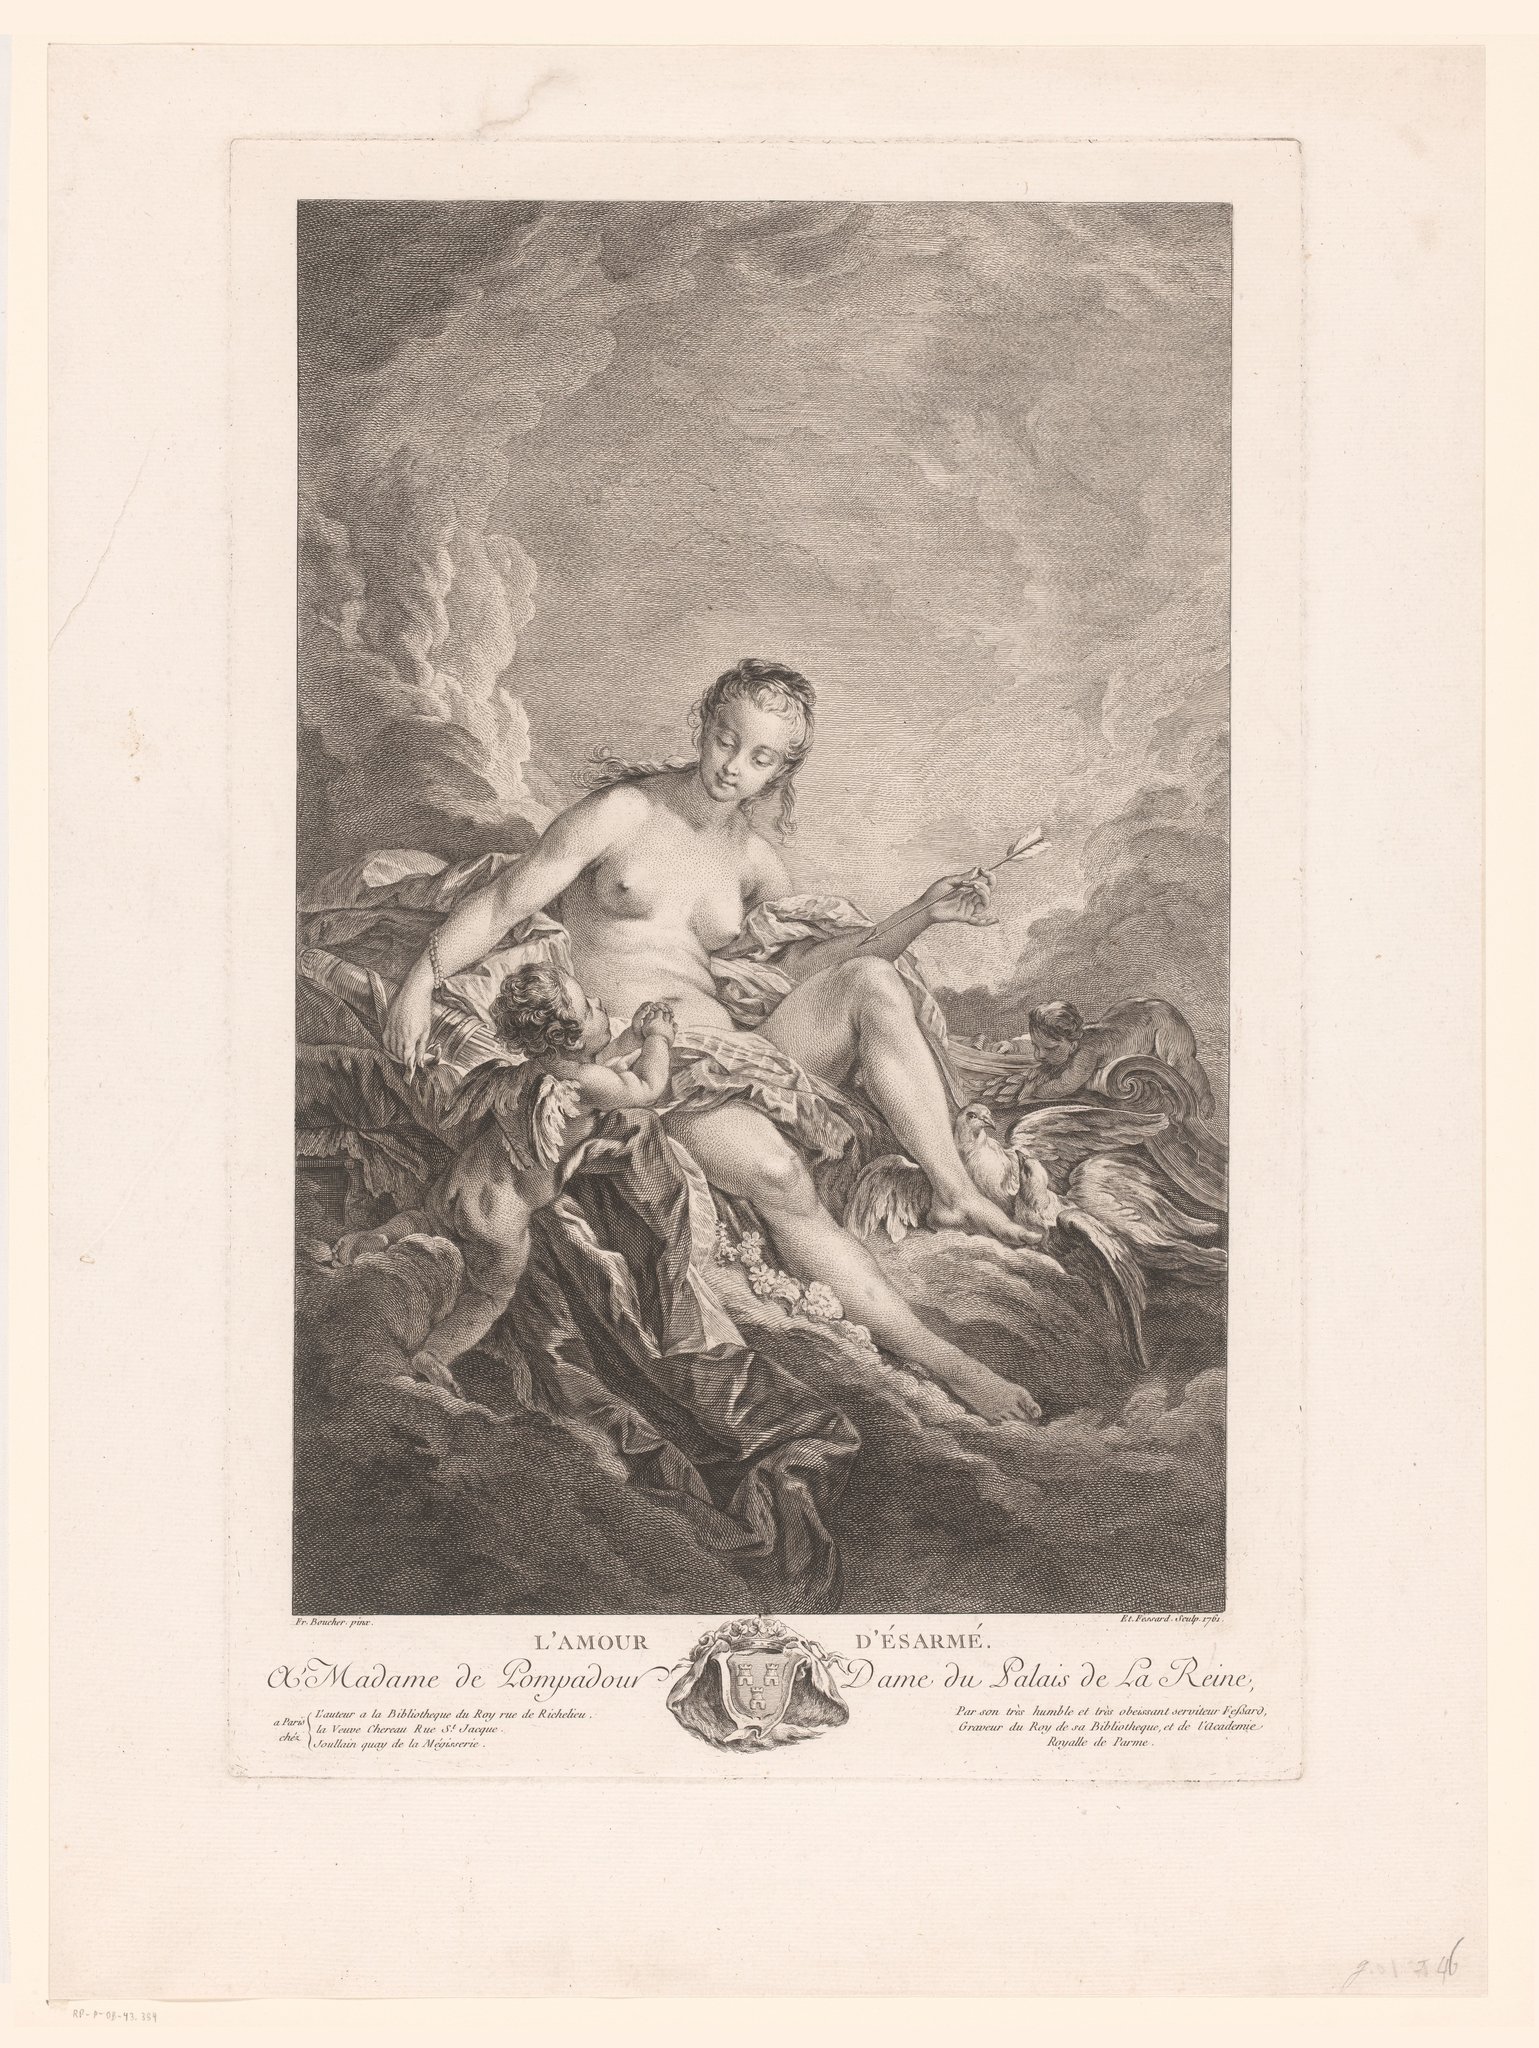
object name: print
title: Liefdespijl van Amor afgenomen door Venus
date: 1761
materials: paper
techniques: engraving, etching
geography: paris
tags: attributes of cupid: arrow(s), other birds: turtle dove, venus and cupid (cupid not being mere attribute)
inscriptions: inscription: ‘1710:’, watermark